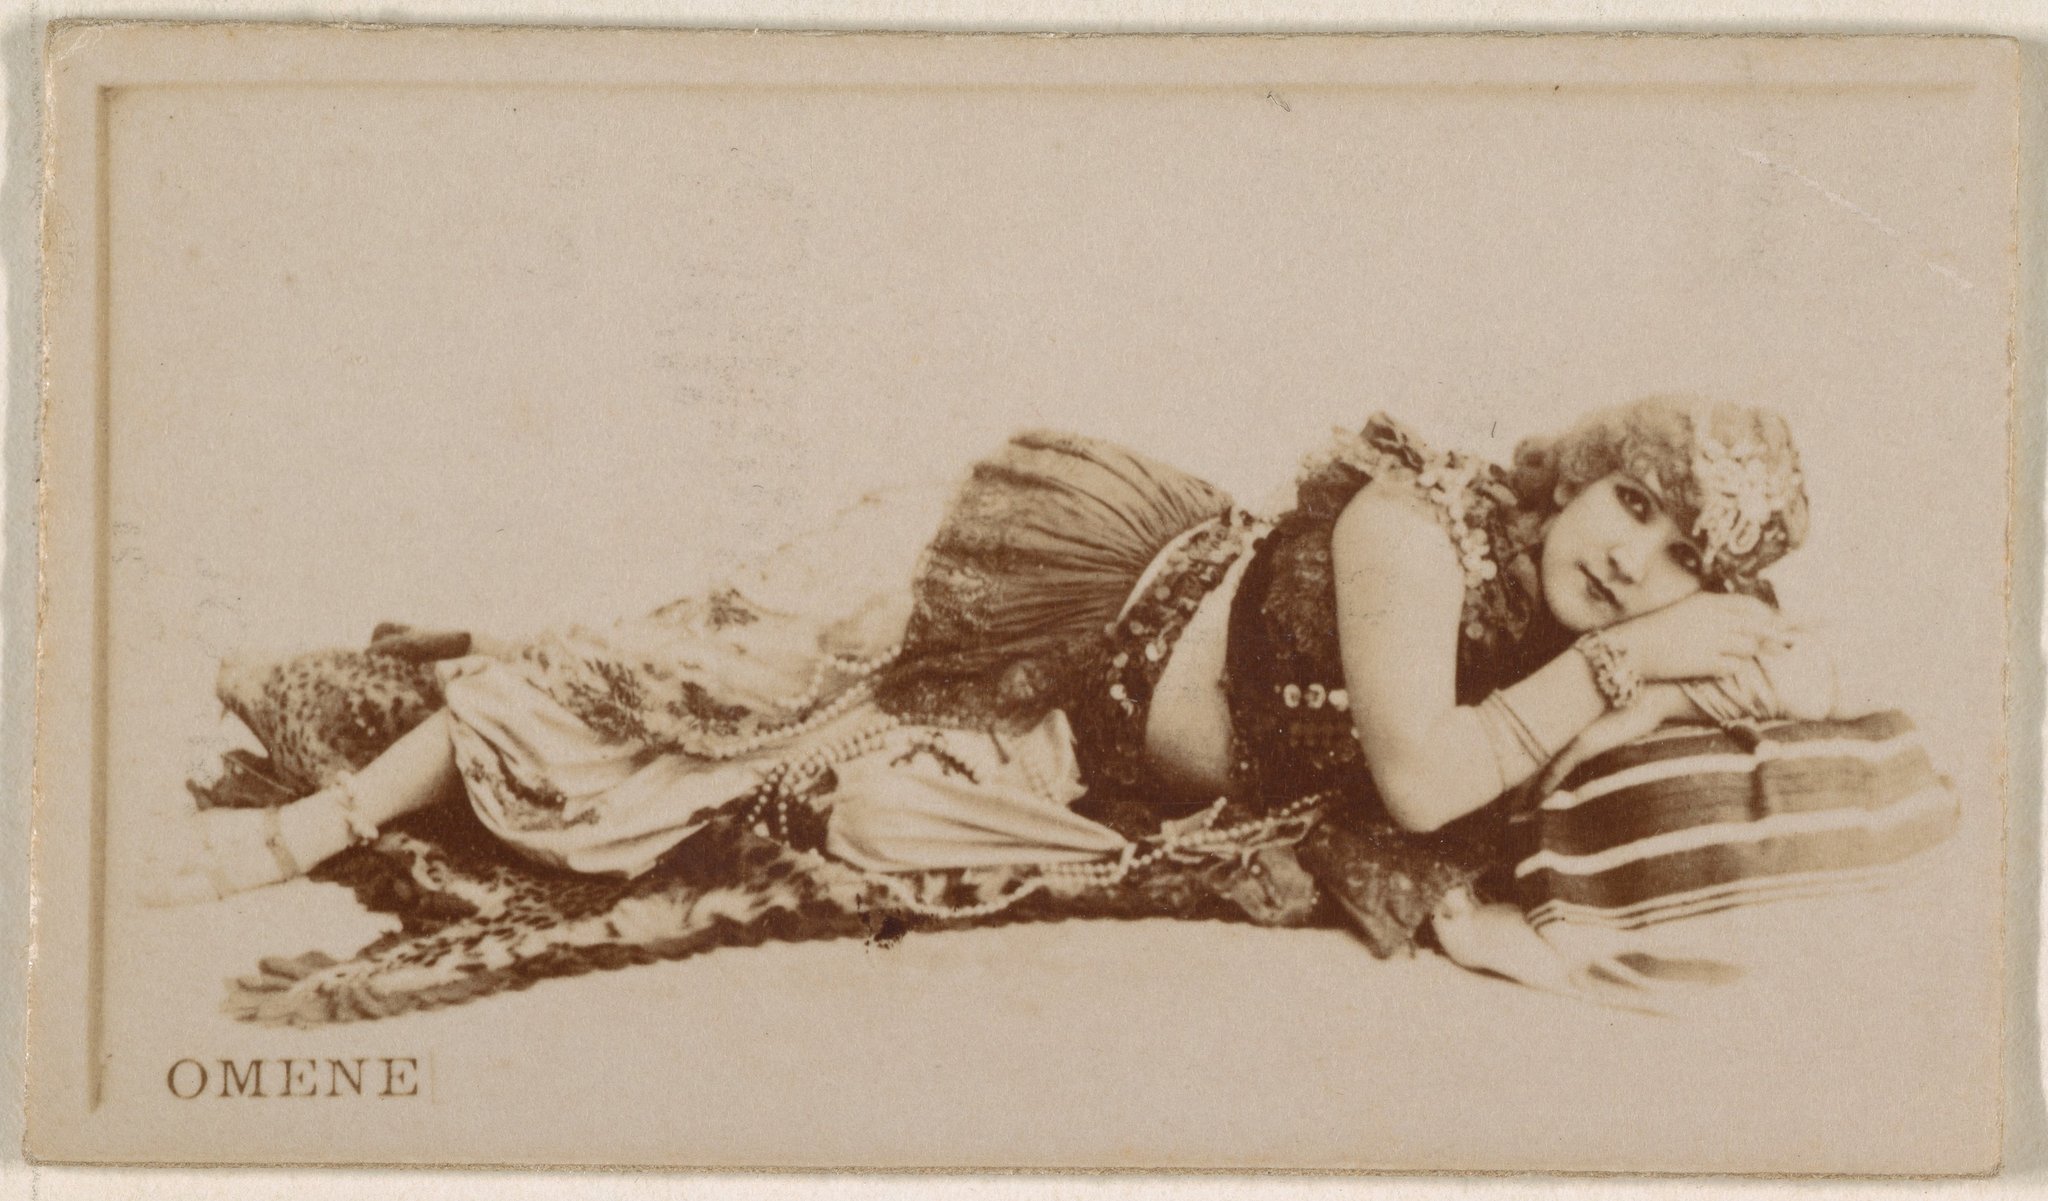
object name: photograph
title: Omene, from the Actresses series (N245) issued by Kinney Brothers to promote Sweet Caporal Cigarettes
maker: kinney brothers tobacco company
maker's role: publisher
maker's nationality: american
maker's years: 1869-2011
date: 1890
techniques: albumen silver print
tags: portraits,women,actresses